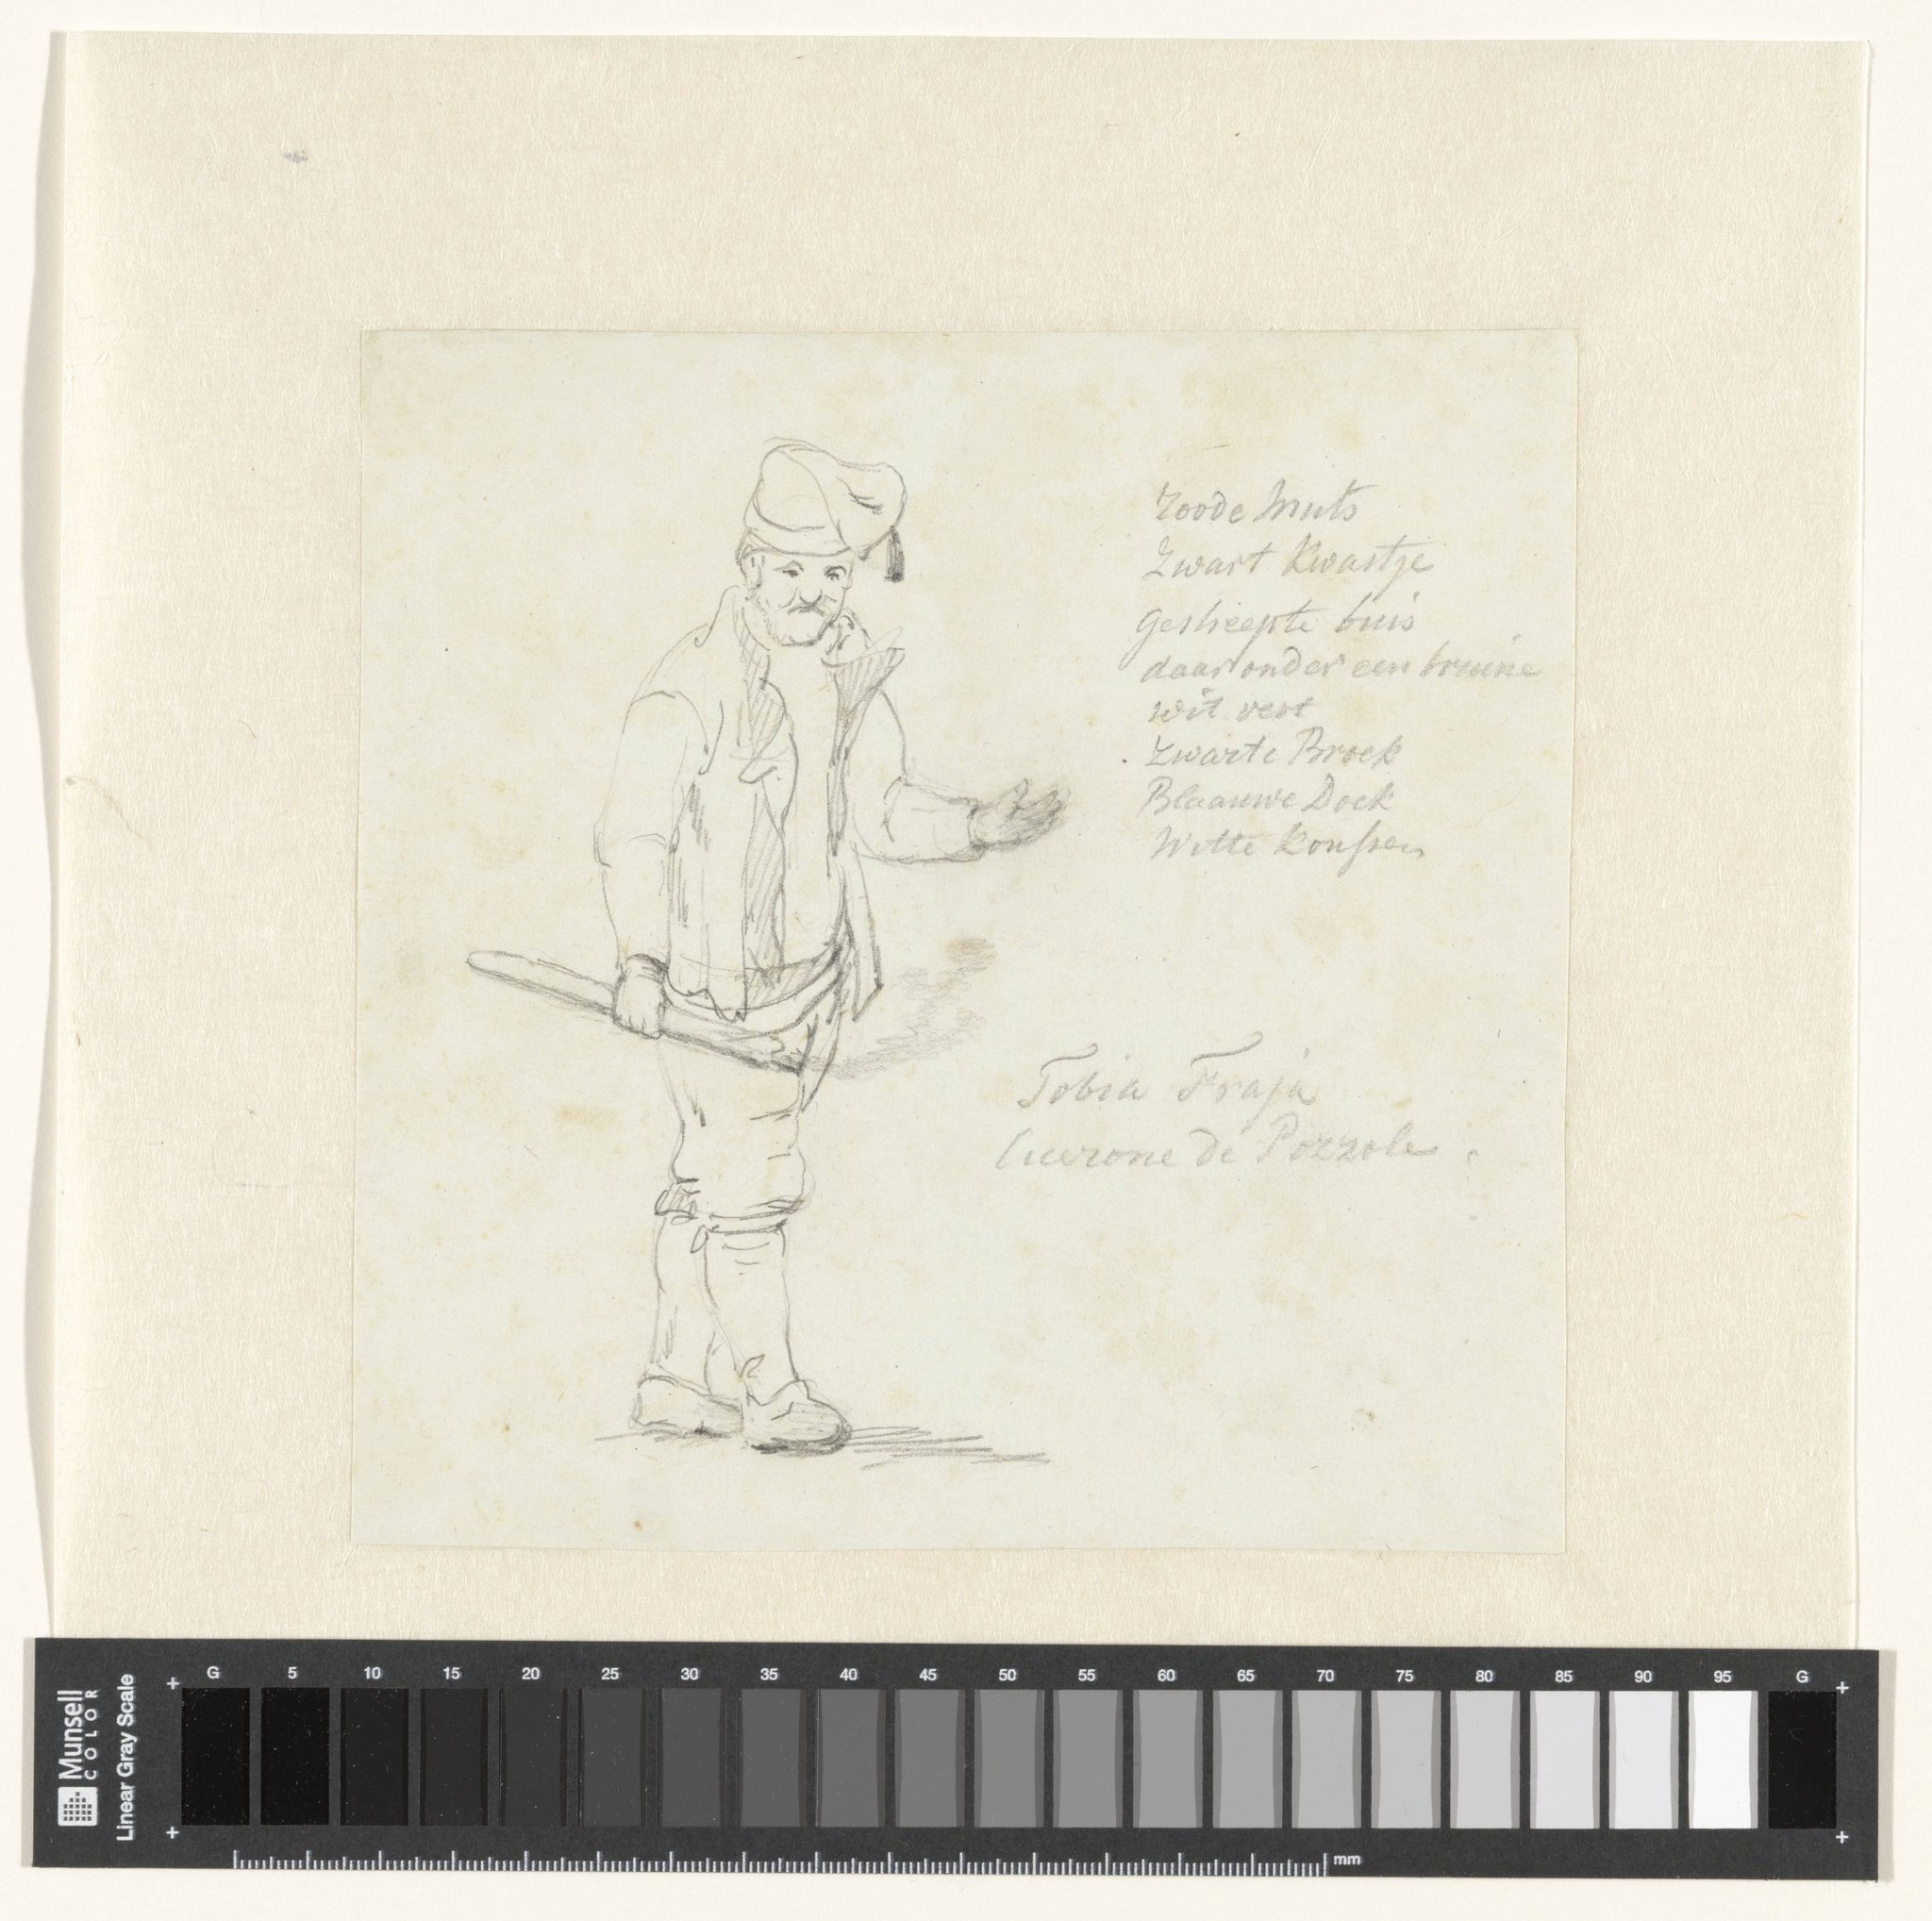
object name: drawing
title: Een gids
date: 1772-1844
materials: chalk, paper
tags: guide (~ conducted tour), italy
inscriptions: inscription: ‘roode muts / zwart kwastje / gestreepte buis / daaronder een bruine / wit vest / Zwarte Broek / Blauwe Doek / witte koussen Tobia Traja / Cicerone de Pozzole.’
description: Tekening uit een groep tekeningen van landschappen en stadsgezichten in Italië (Rome, Tivoli, Civita Castellana en Pozzuoli).